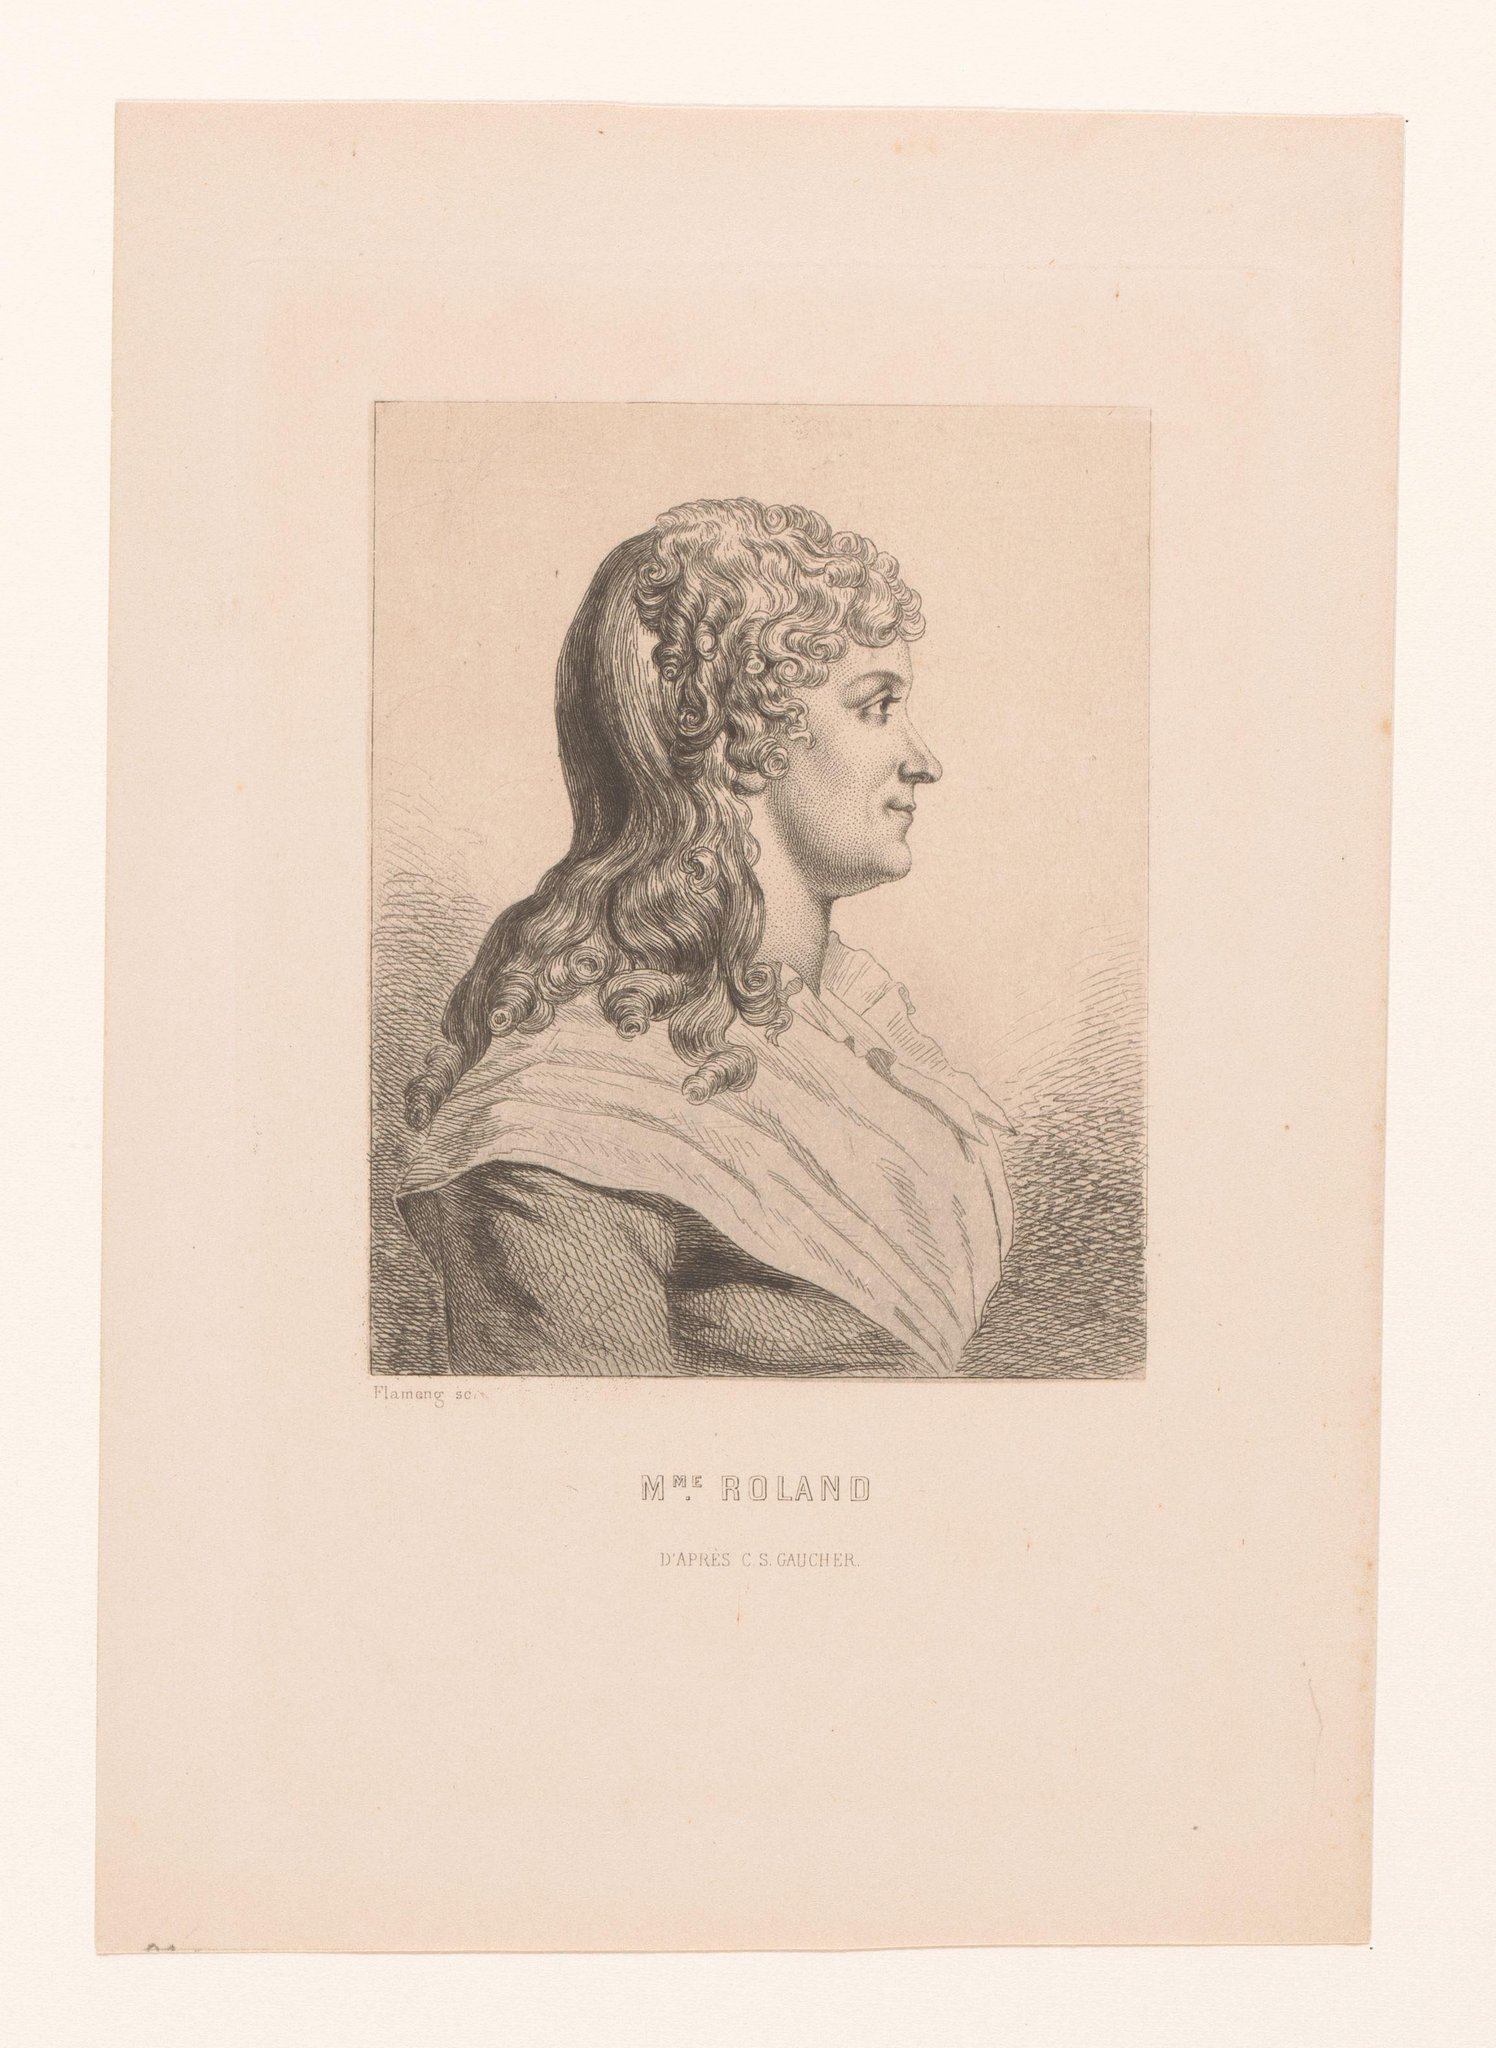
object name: print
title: Mme Roland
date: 1841-1910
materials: paper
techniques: etching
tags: paris, historical persons - bb - woman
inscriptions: collector's mark: Lugt 2228